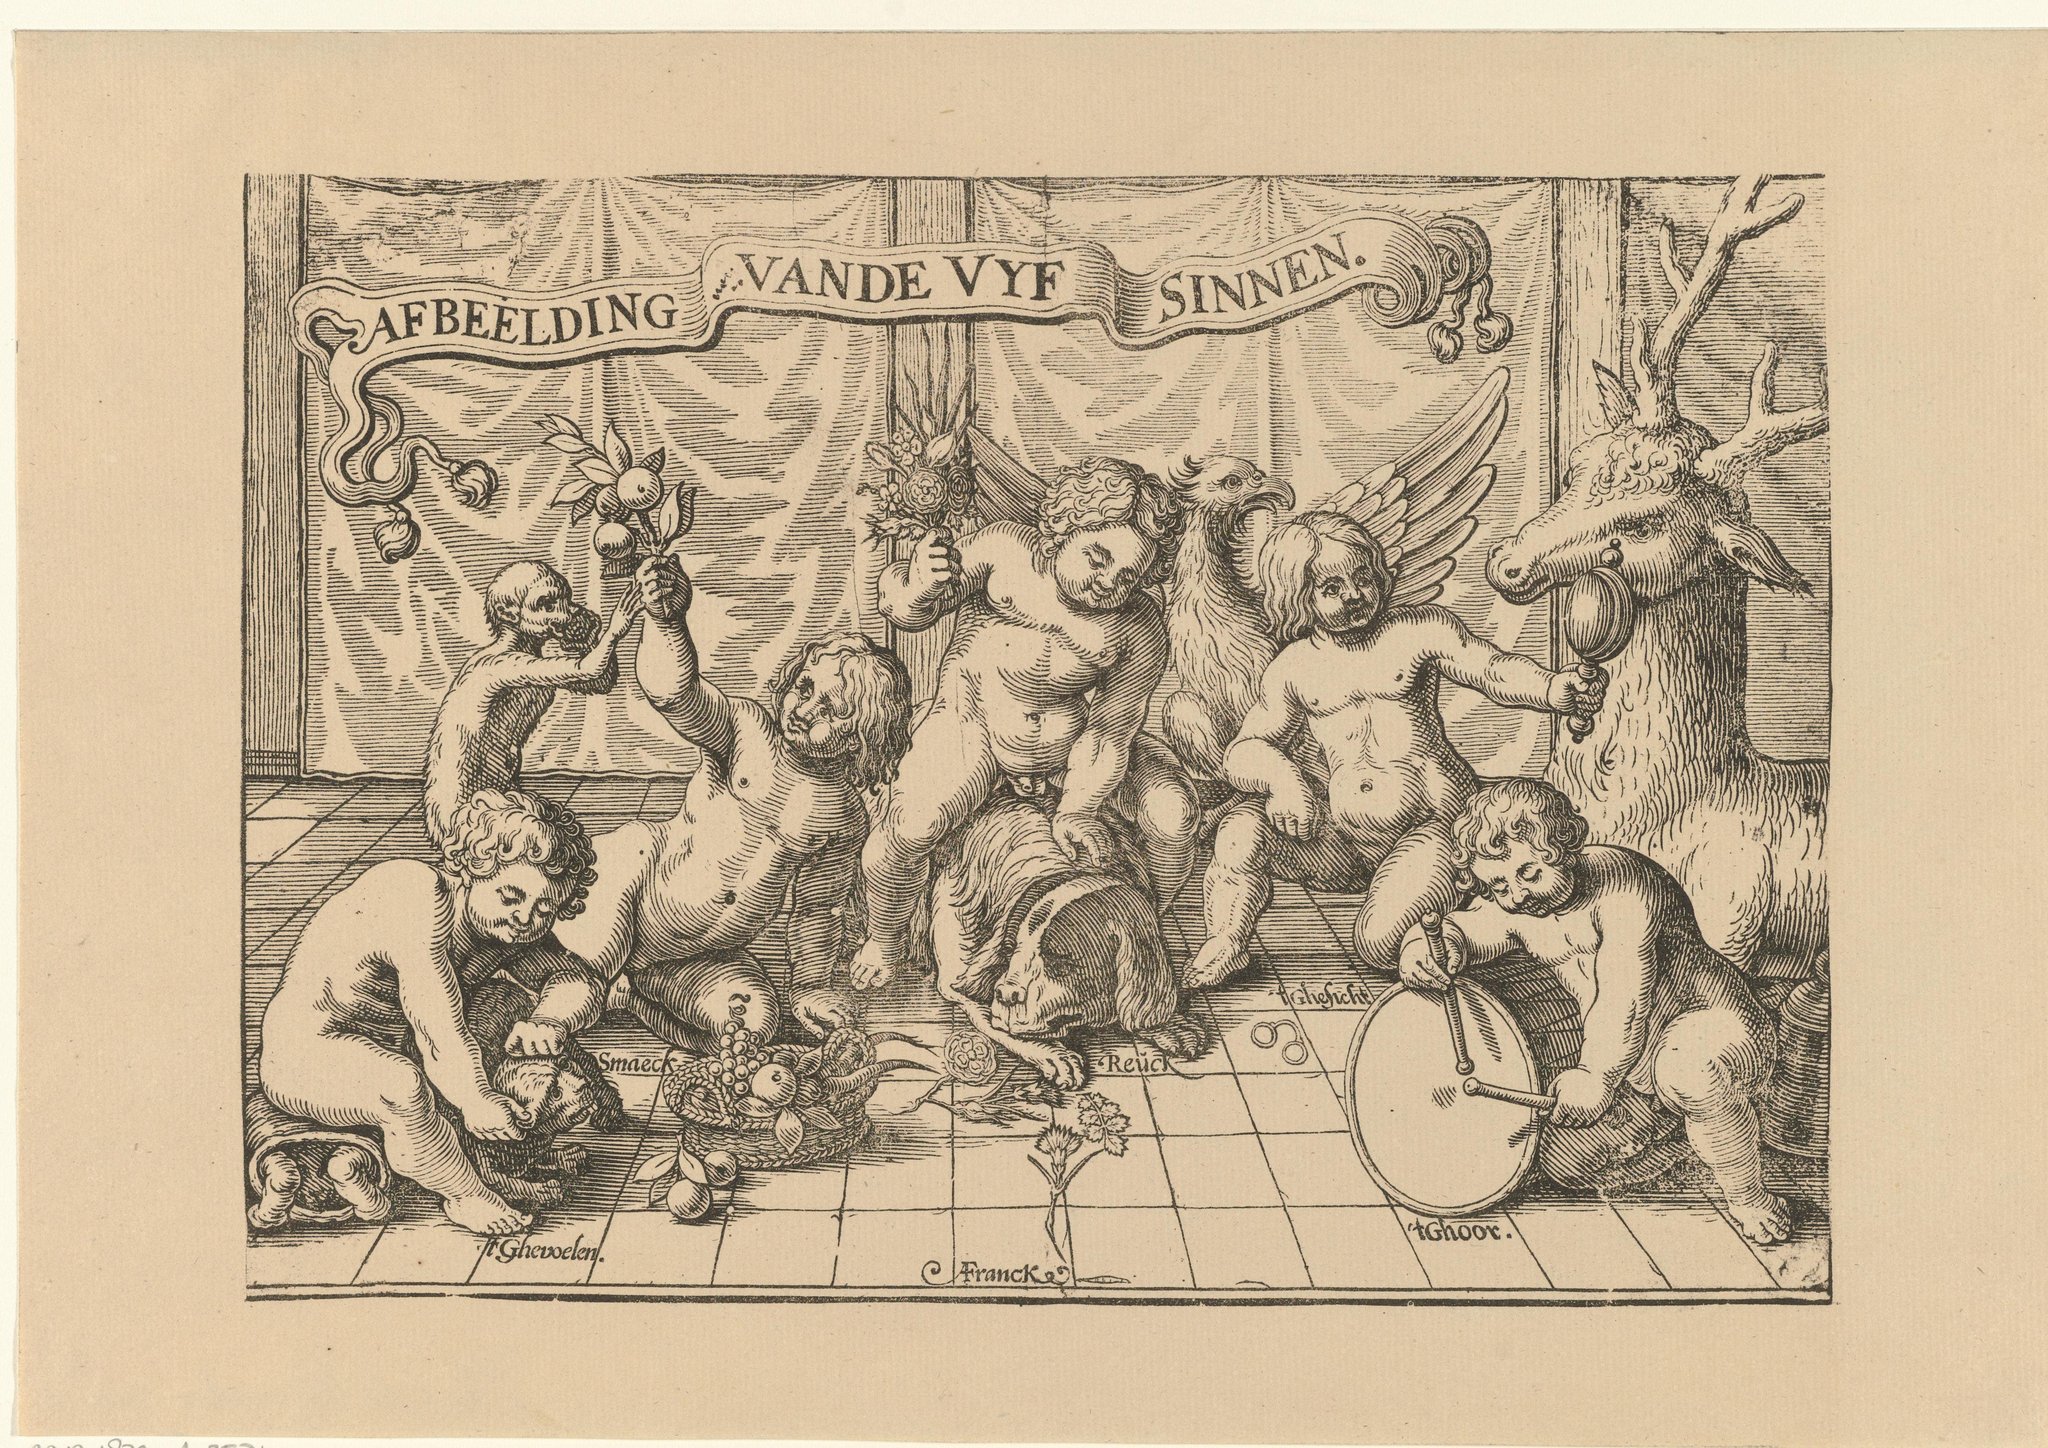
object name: print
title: Afbeelding vande vyf sinnen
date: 1850-1879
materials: paper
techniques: photolithography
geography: netherlands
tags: flowers, the (five) senses, mirror, drum (musical instrument), fruits, cupids: 'amores', 'amoretti', 'putti'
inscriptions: collector's mark: Lugt 2228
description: Vijf putti spelen met allegorische objecten die de vijf zintuigen voorstellen, waaronder een trommel voor horen, een spiegel voor zien, bloemen voor ruiken, fruit voor proeven en de vacht van een dier voor voelen.